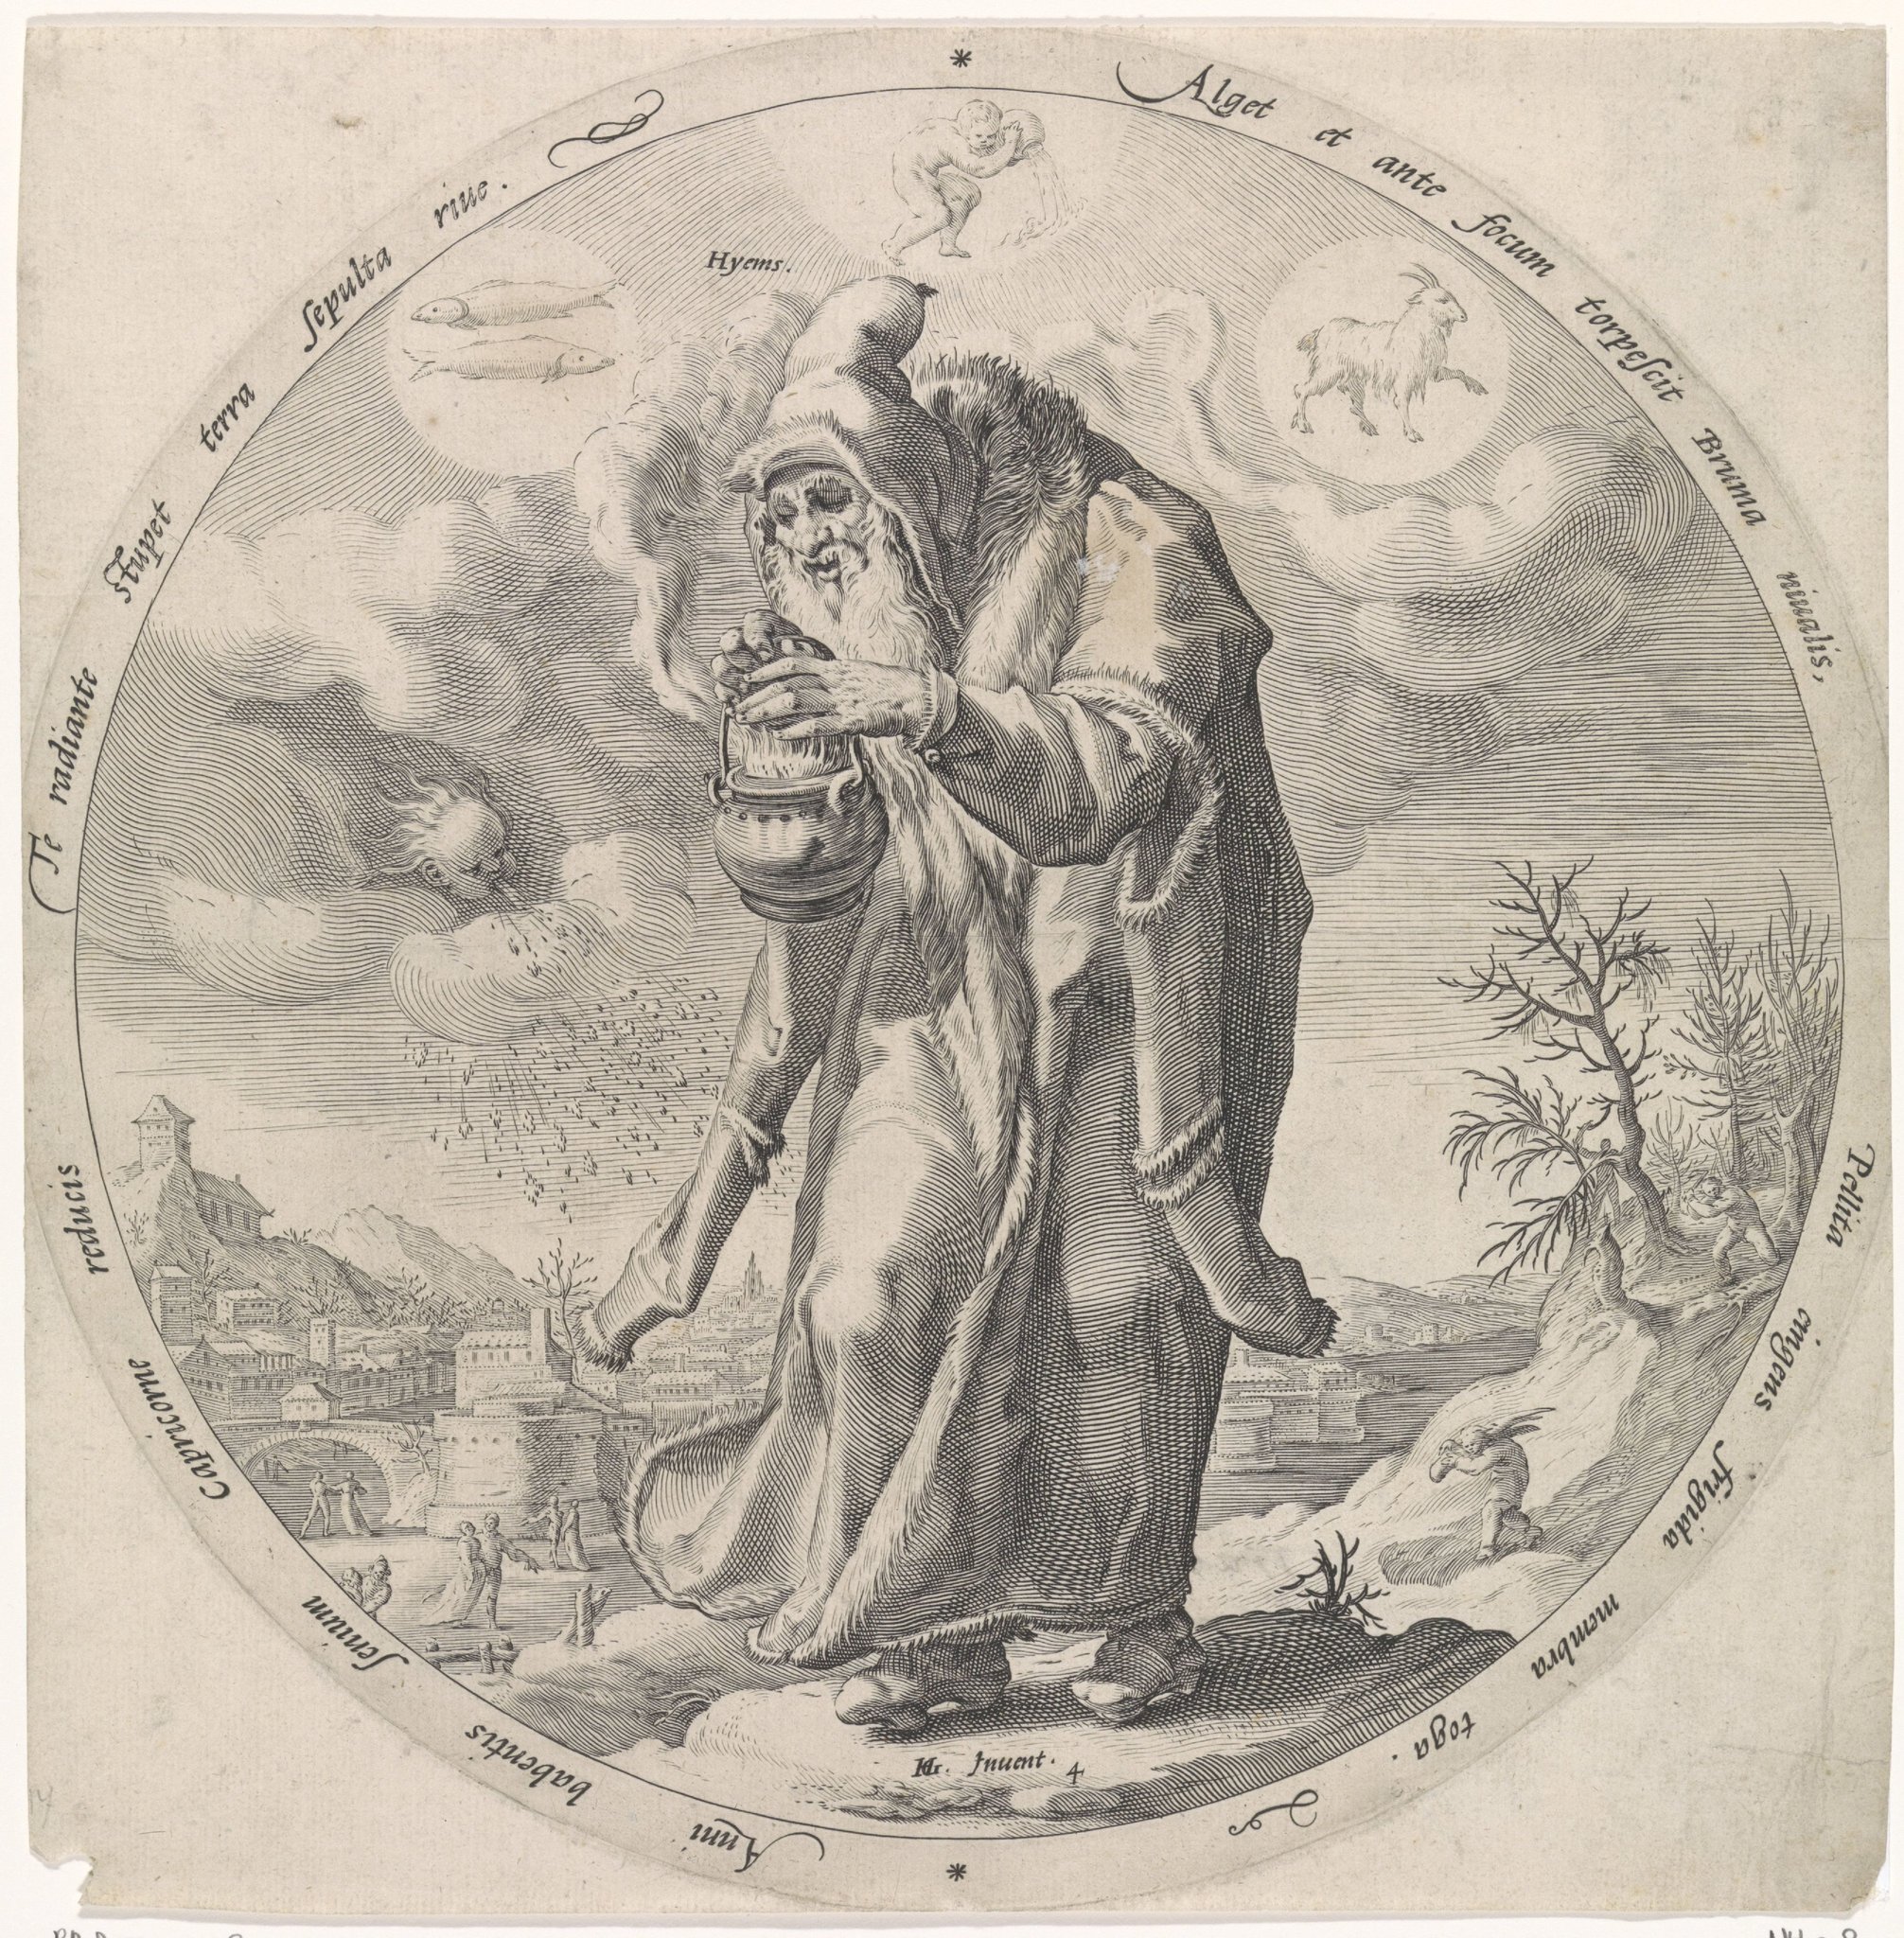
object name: print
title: Hyems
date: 1589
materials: paper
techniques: engraving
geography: haarlem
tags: winter, 'hyems'; 'inverno' (ripa)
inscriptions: collector's mark: Lugt 240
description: Personificatie van de winter: een oude man in een mantel met bont, zich warmend aan een vuurtest. Op de achtergrond hakken figuren hout en wordt er pret gemaakt op het ijs. Bovenaan de bijbehorende tekens van de dierenriem: Vissen, Waterman en Steenbok.